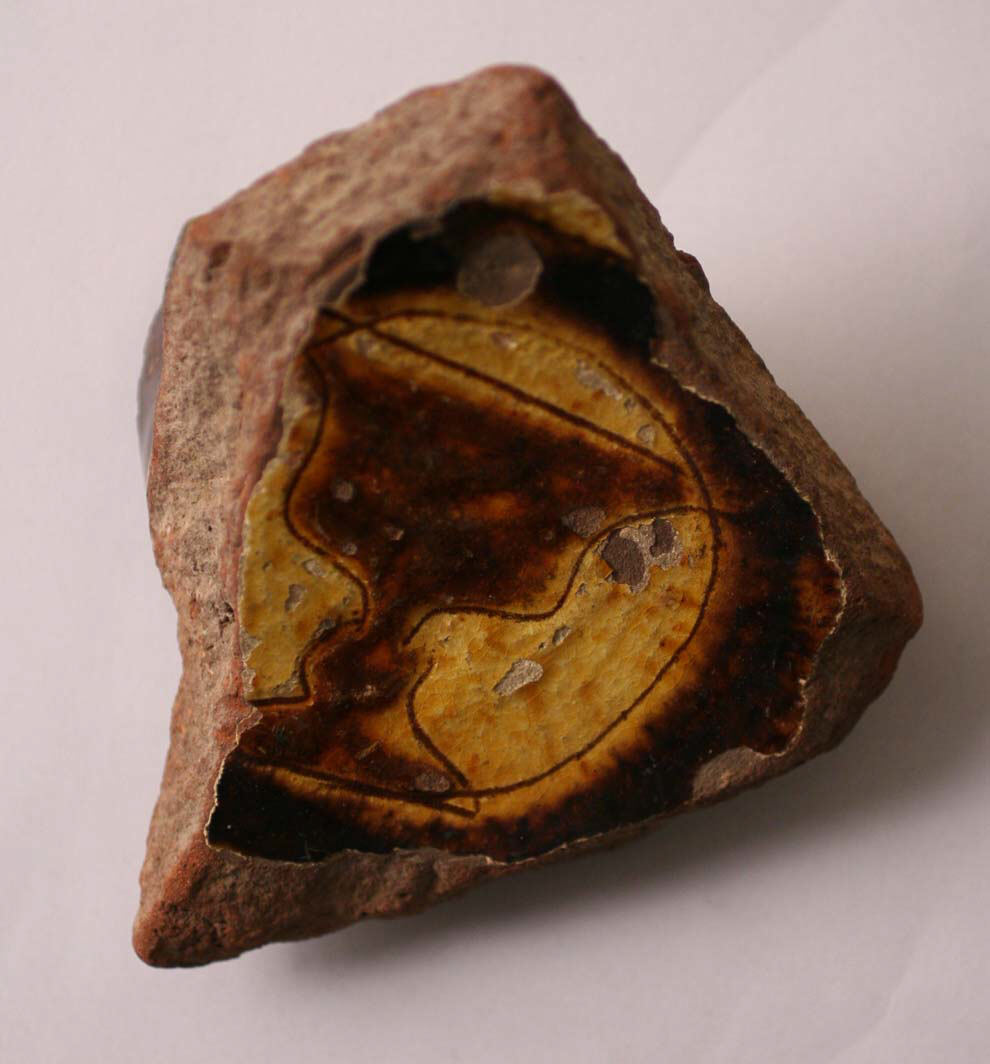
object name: ceramic fragment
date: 1301-1500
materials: earthenware, glaze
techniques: coloring, incising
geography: egypt